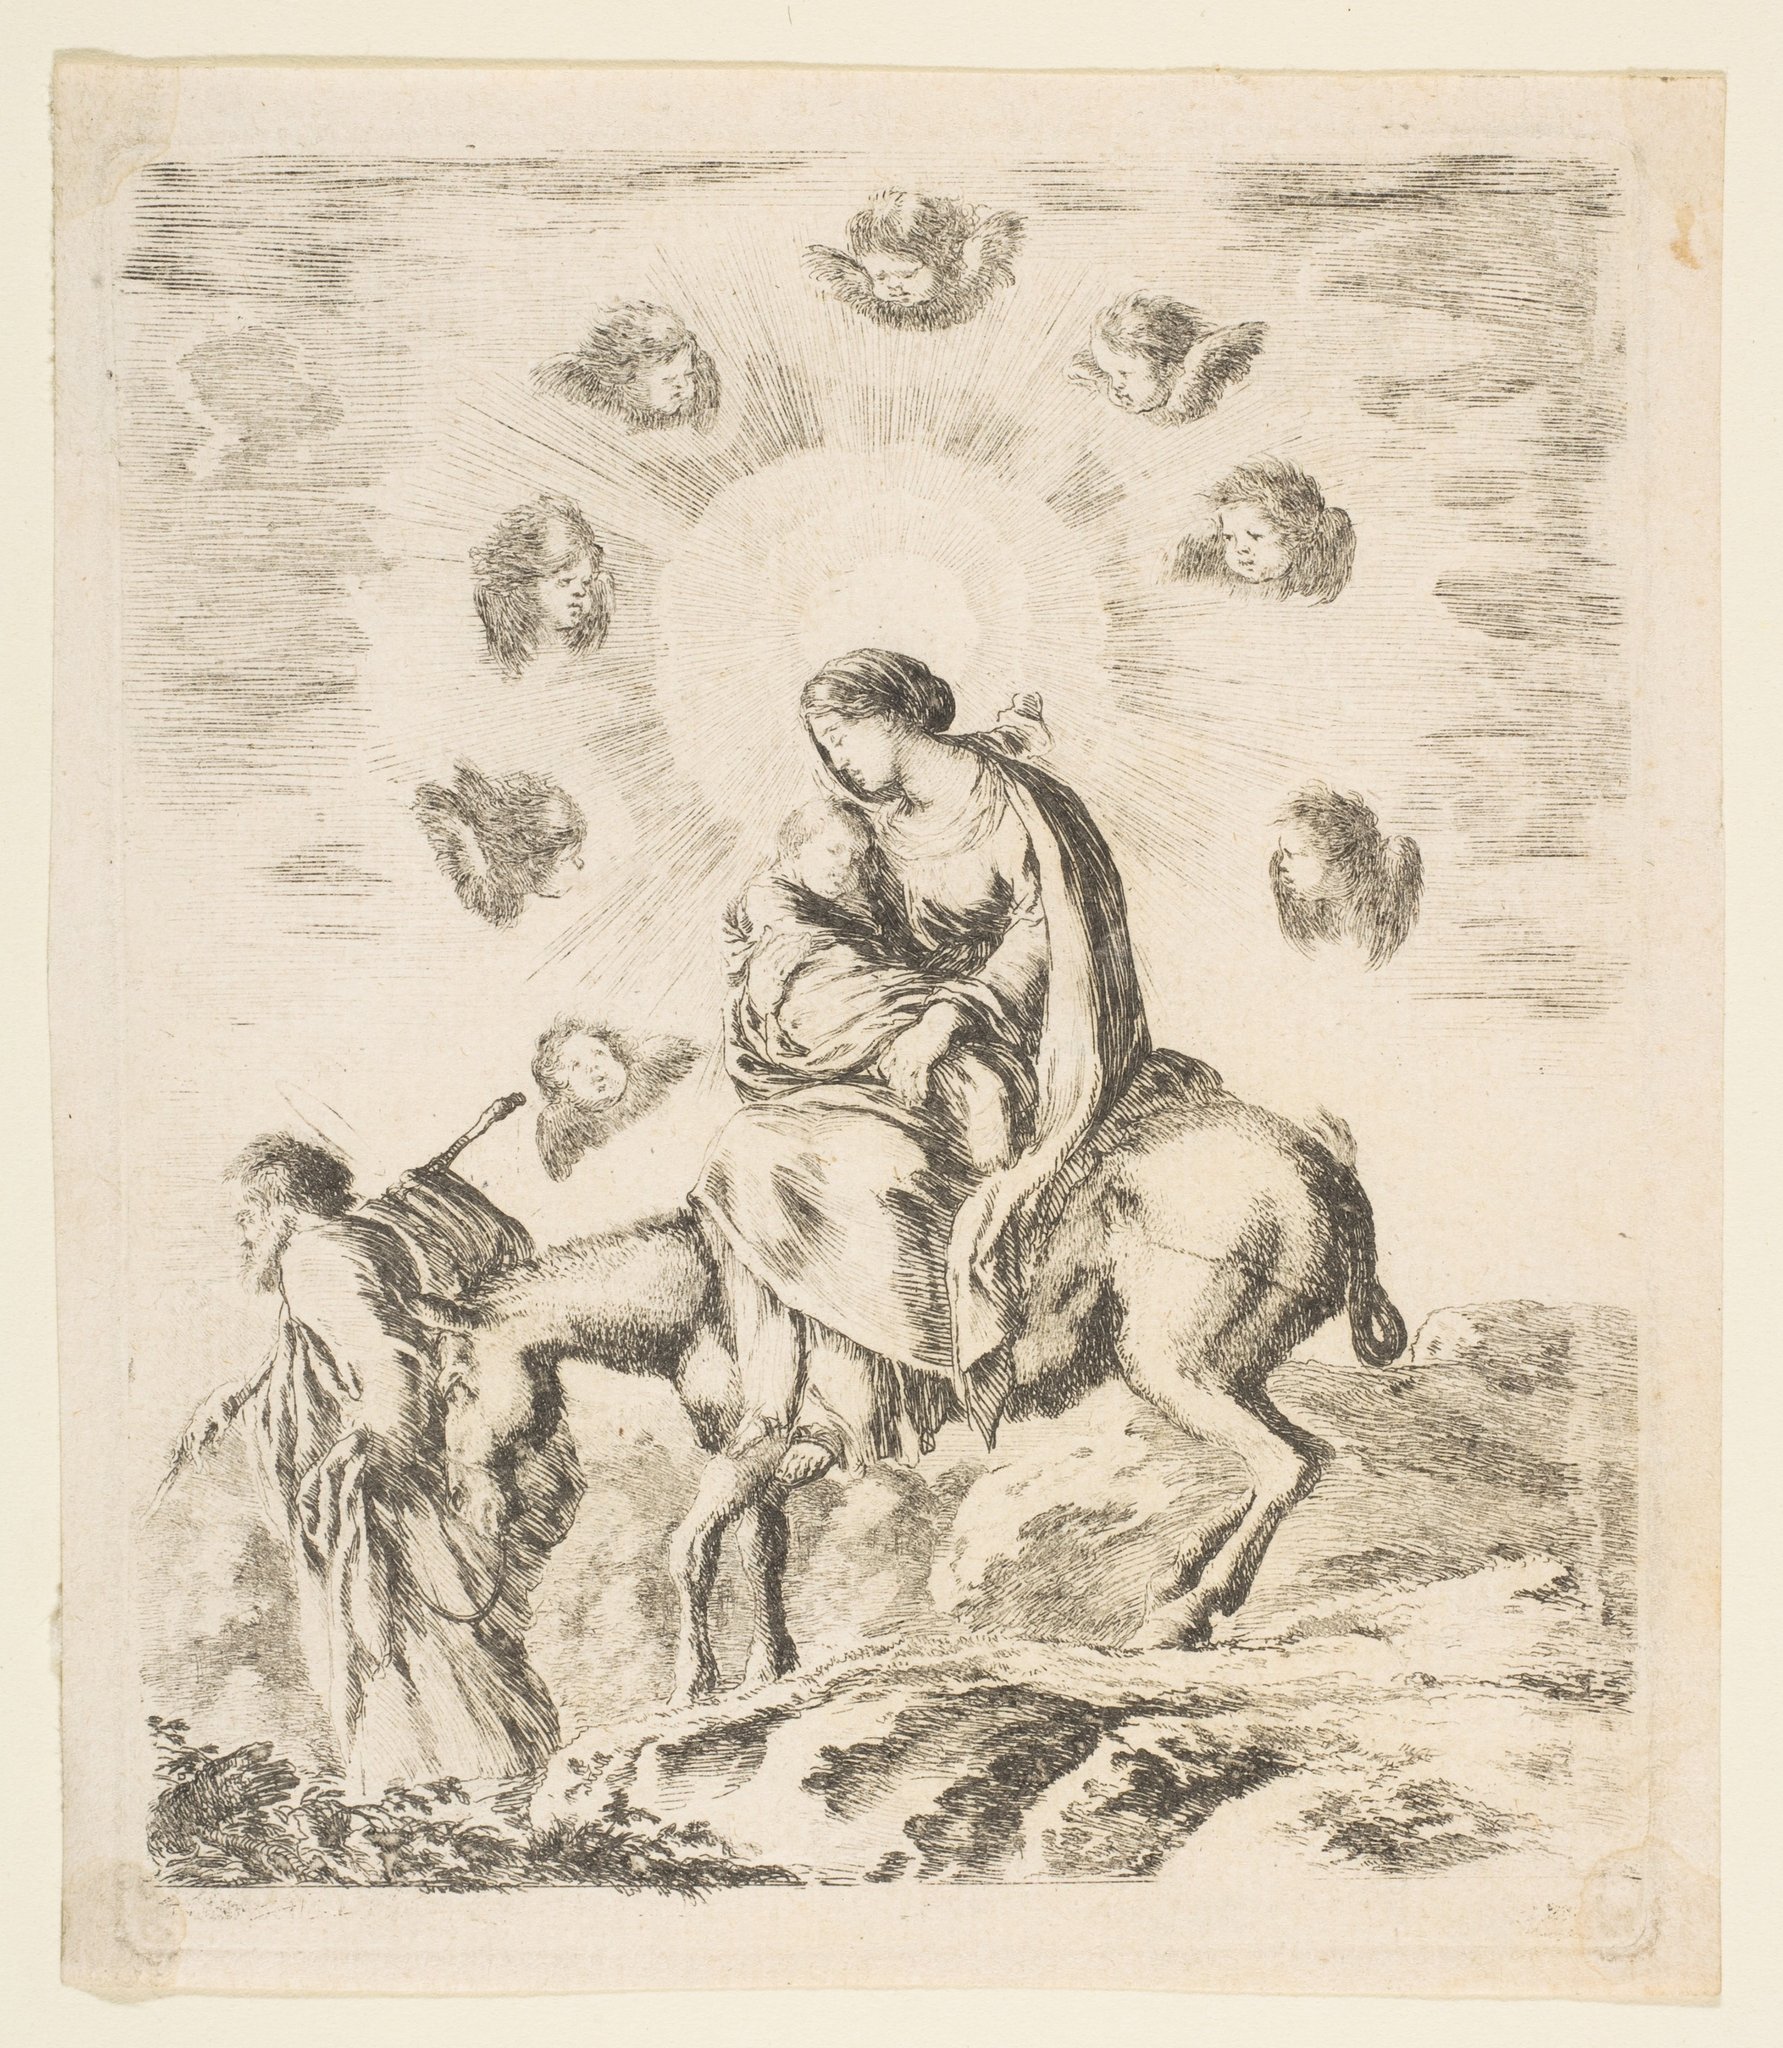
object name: print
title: Flight into Egypt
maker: stefano della bella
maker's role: artist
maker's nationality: italian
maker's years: 1610-1664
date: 1641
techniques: etching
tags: donkeys,christ,holy family,saint joseph,virgin mary